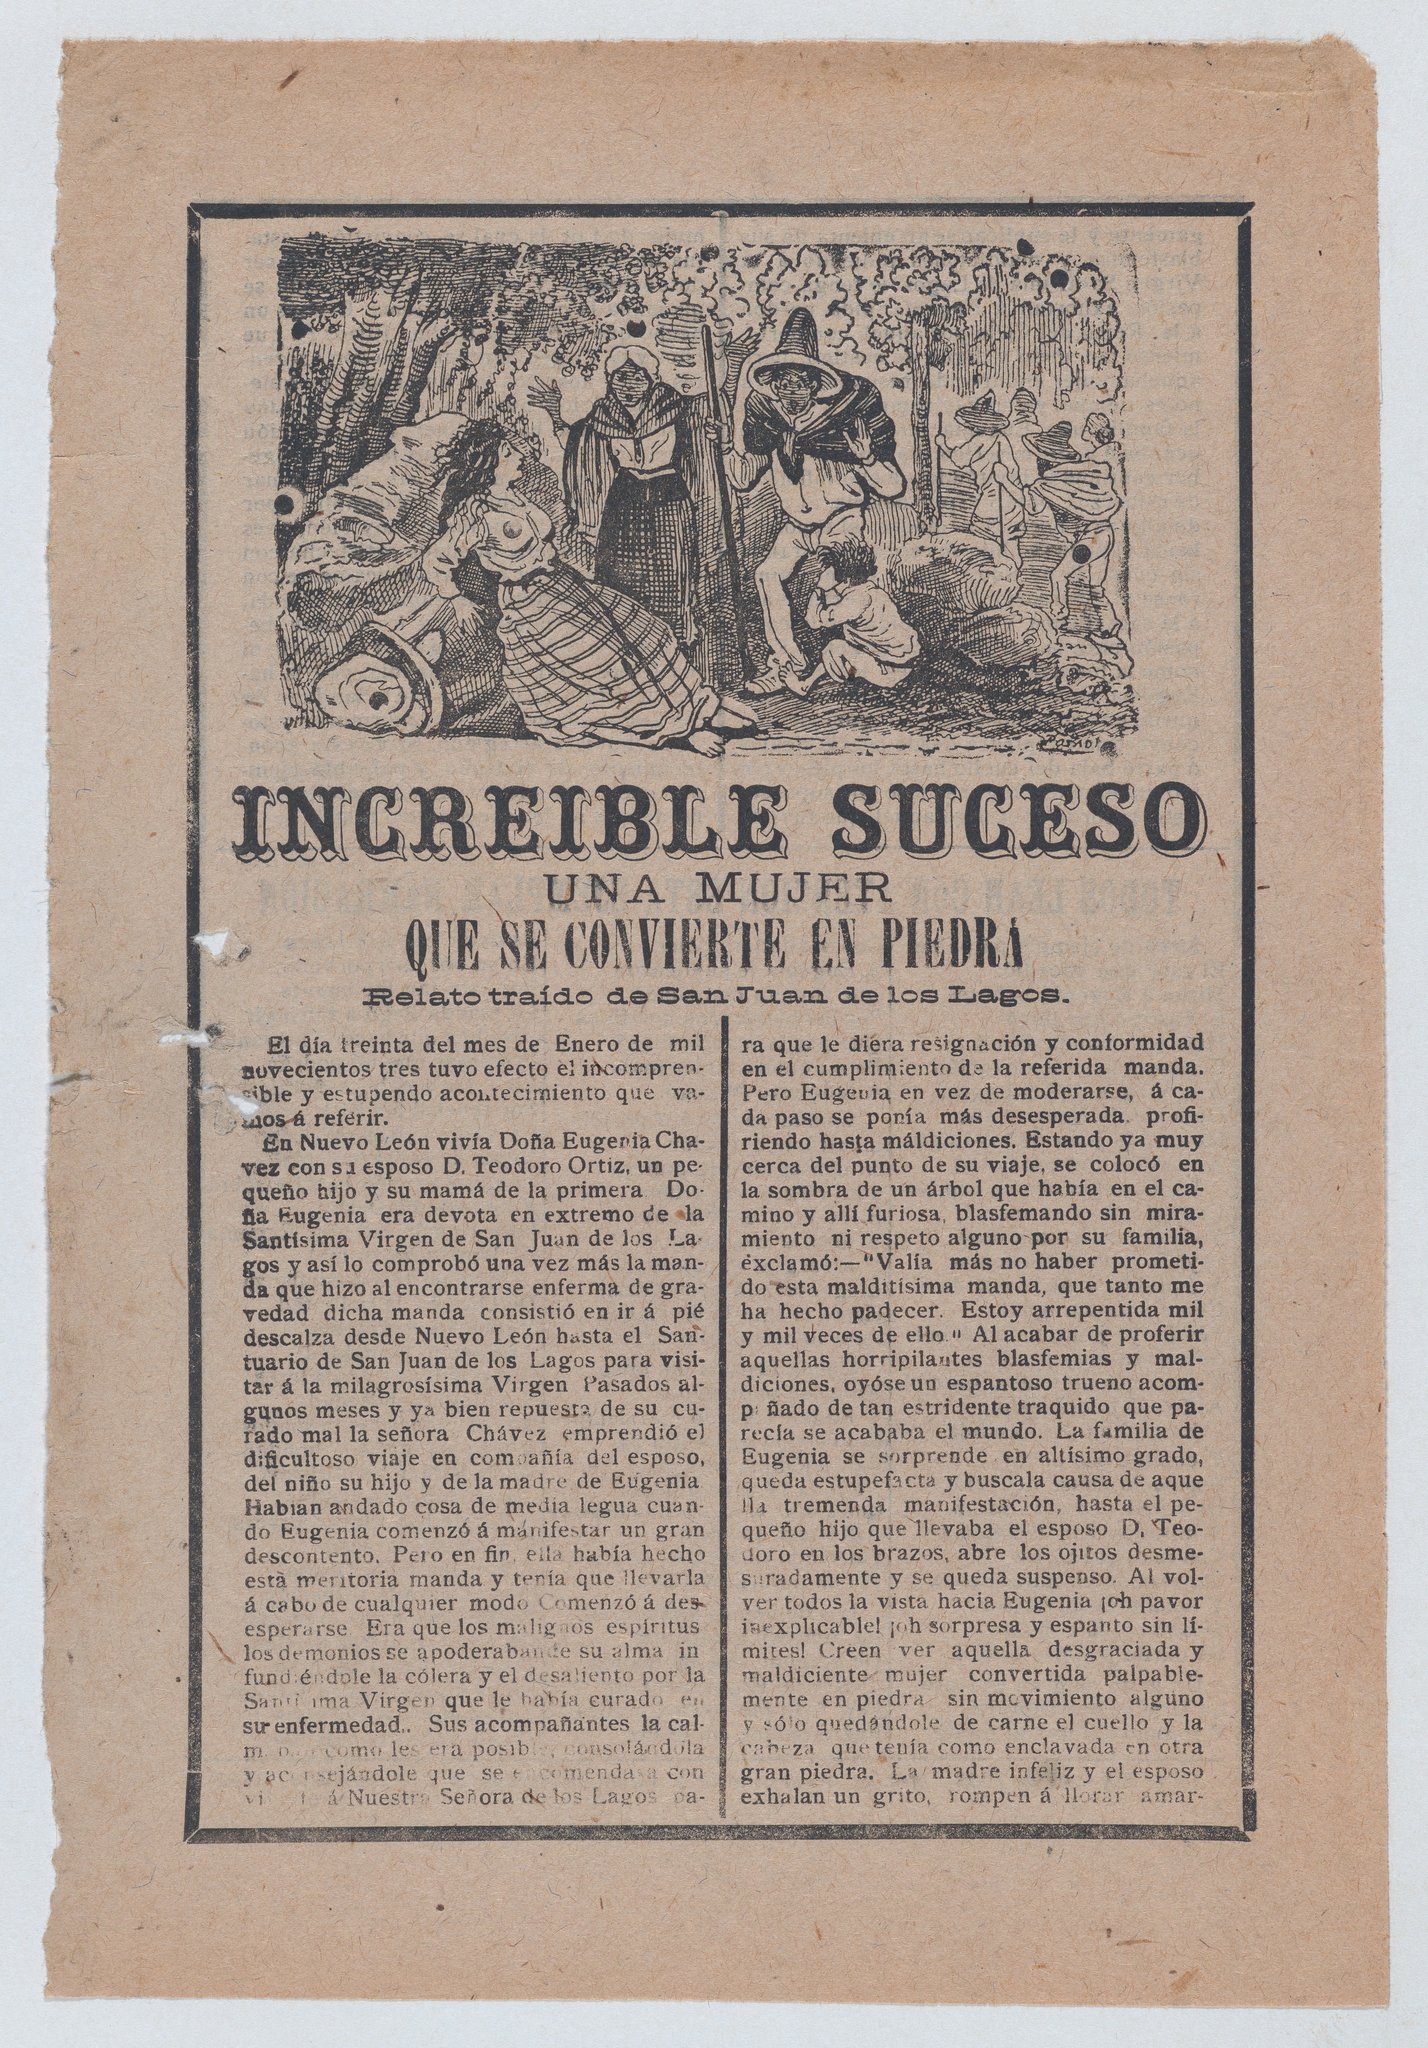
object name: print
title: Broadsheet relating to a story about a woman who has turned into stone, a group of people discovering her in the woods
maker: josé guadalupe posada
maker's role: artist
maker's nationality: mexican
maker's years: 1852-1913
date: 1903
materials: metal, paper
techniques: engraving, letterpress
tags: men,women